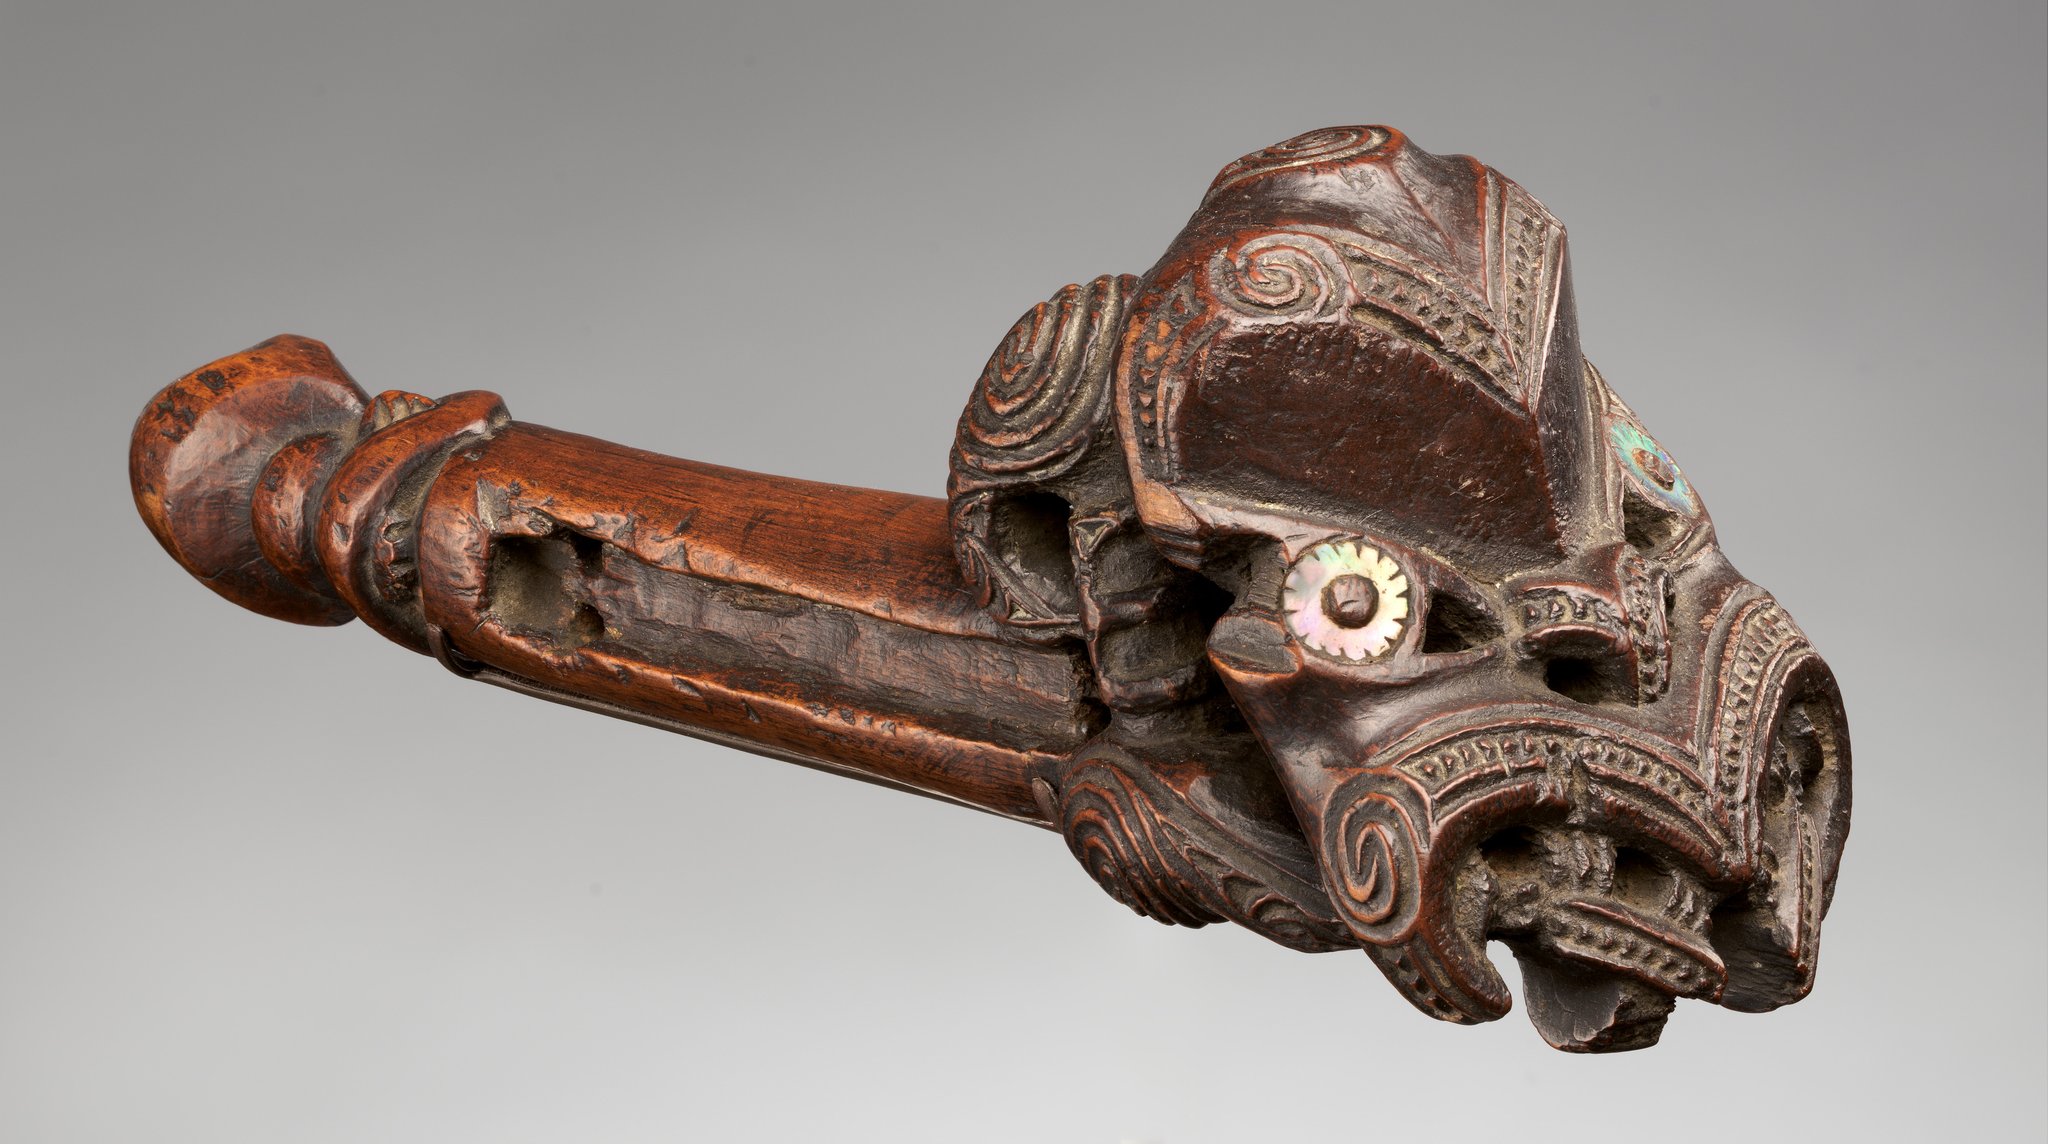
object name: religious ritual object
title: Ritual Object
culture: maori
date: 1801-1900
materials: shell, wood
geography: new zealand